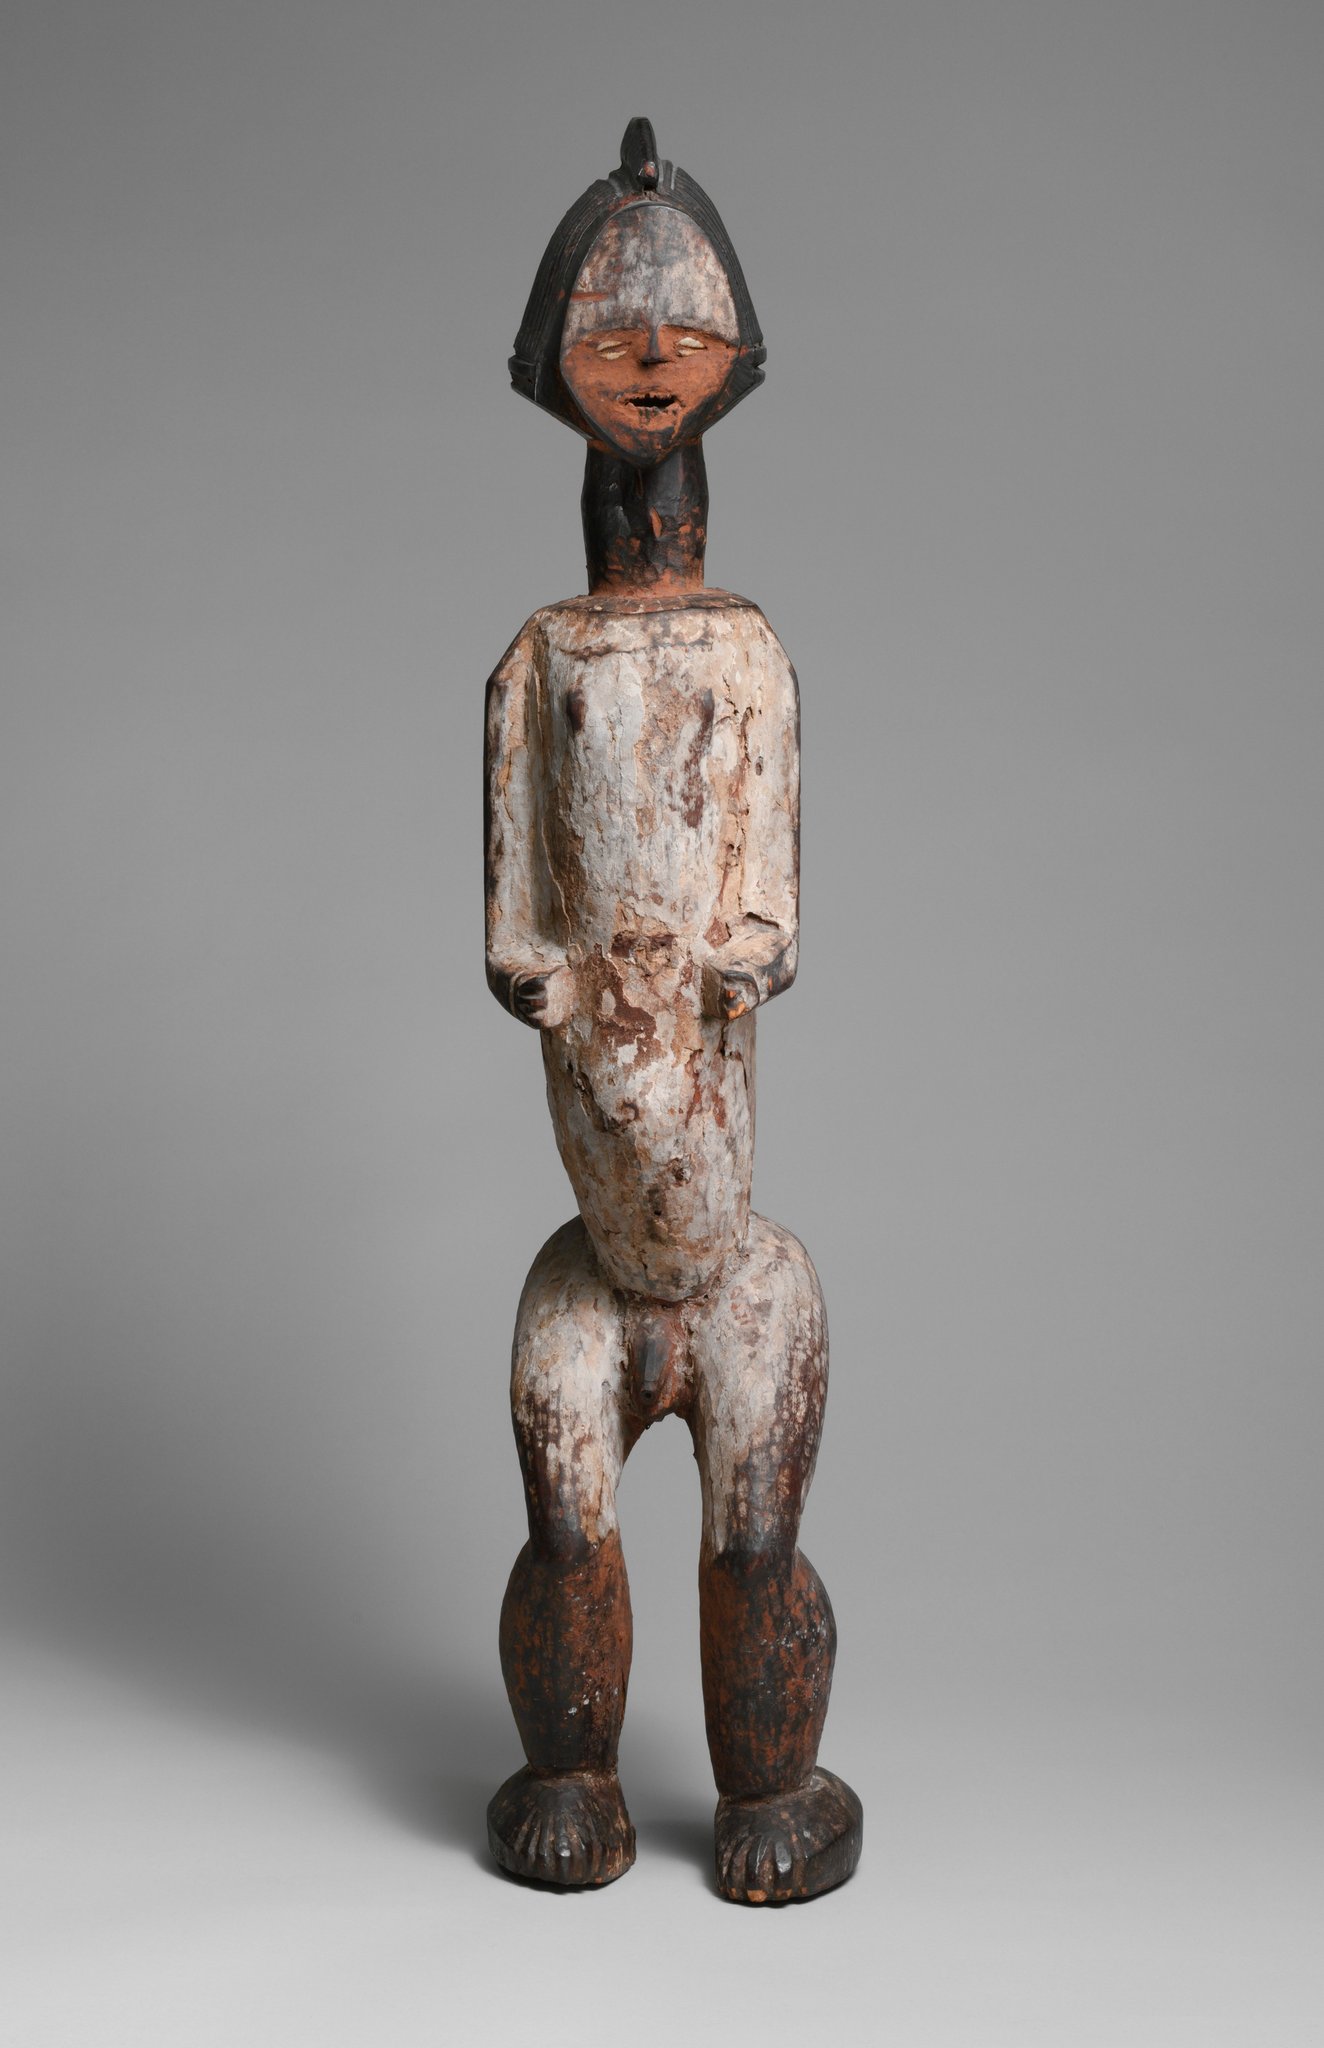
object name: reliquary figure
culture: kota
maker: mbete-kota artist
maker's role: artist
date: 1801-1900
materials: metal, pigment, shell, wood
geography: gabon or republic of congo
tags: male nudes